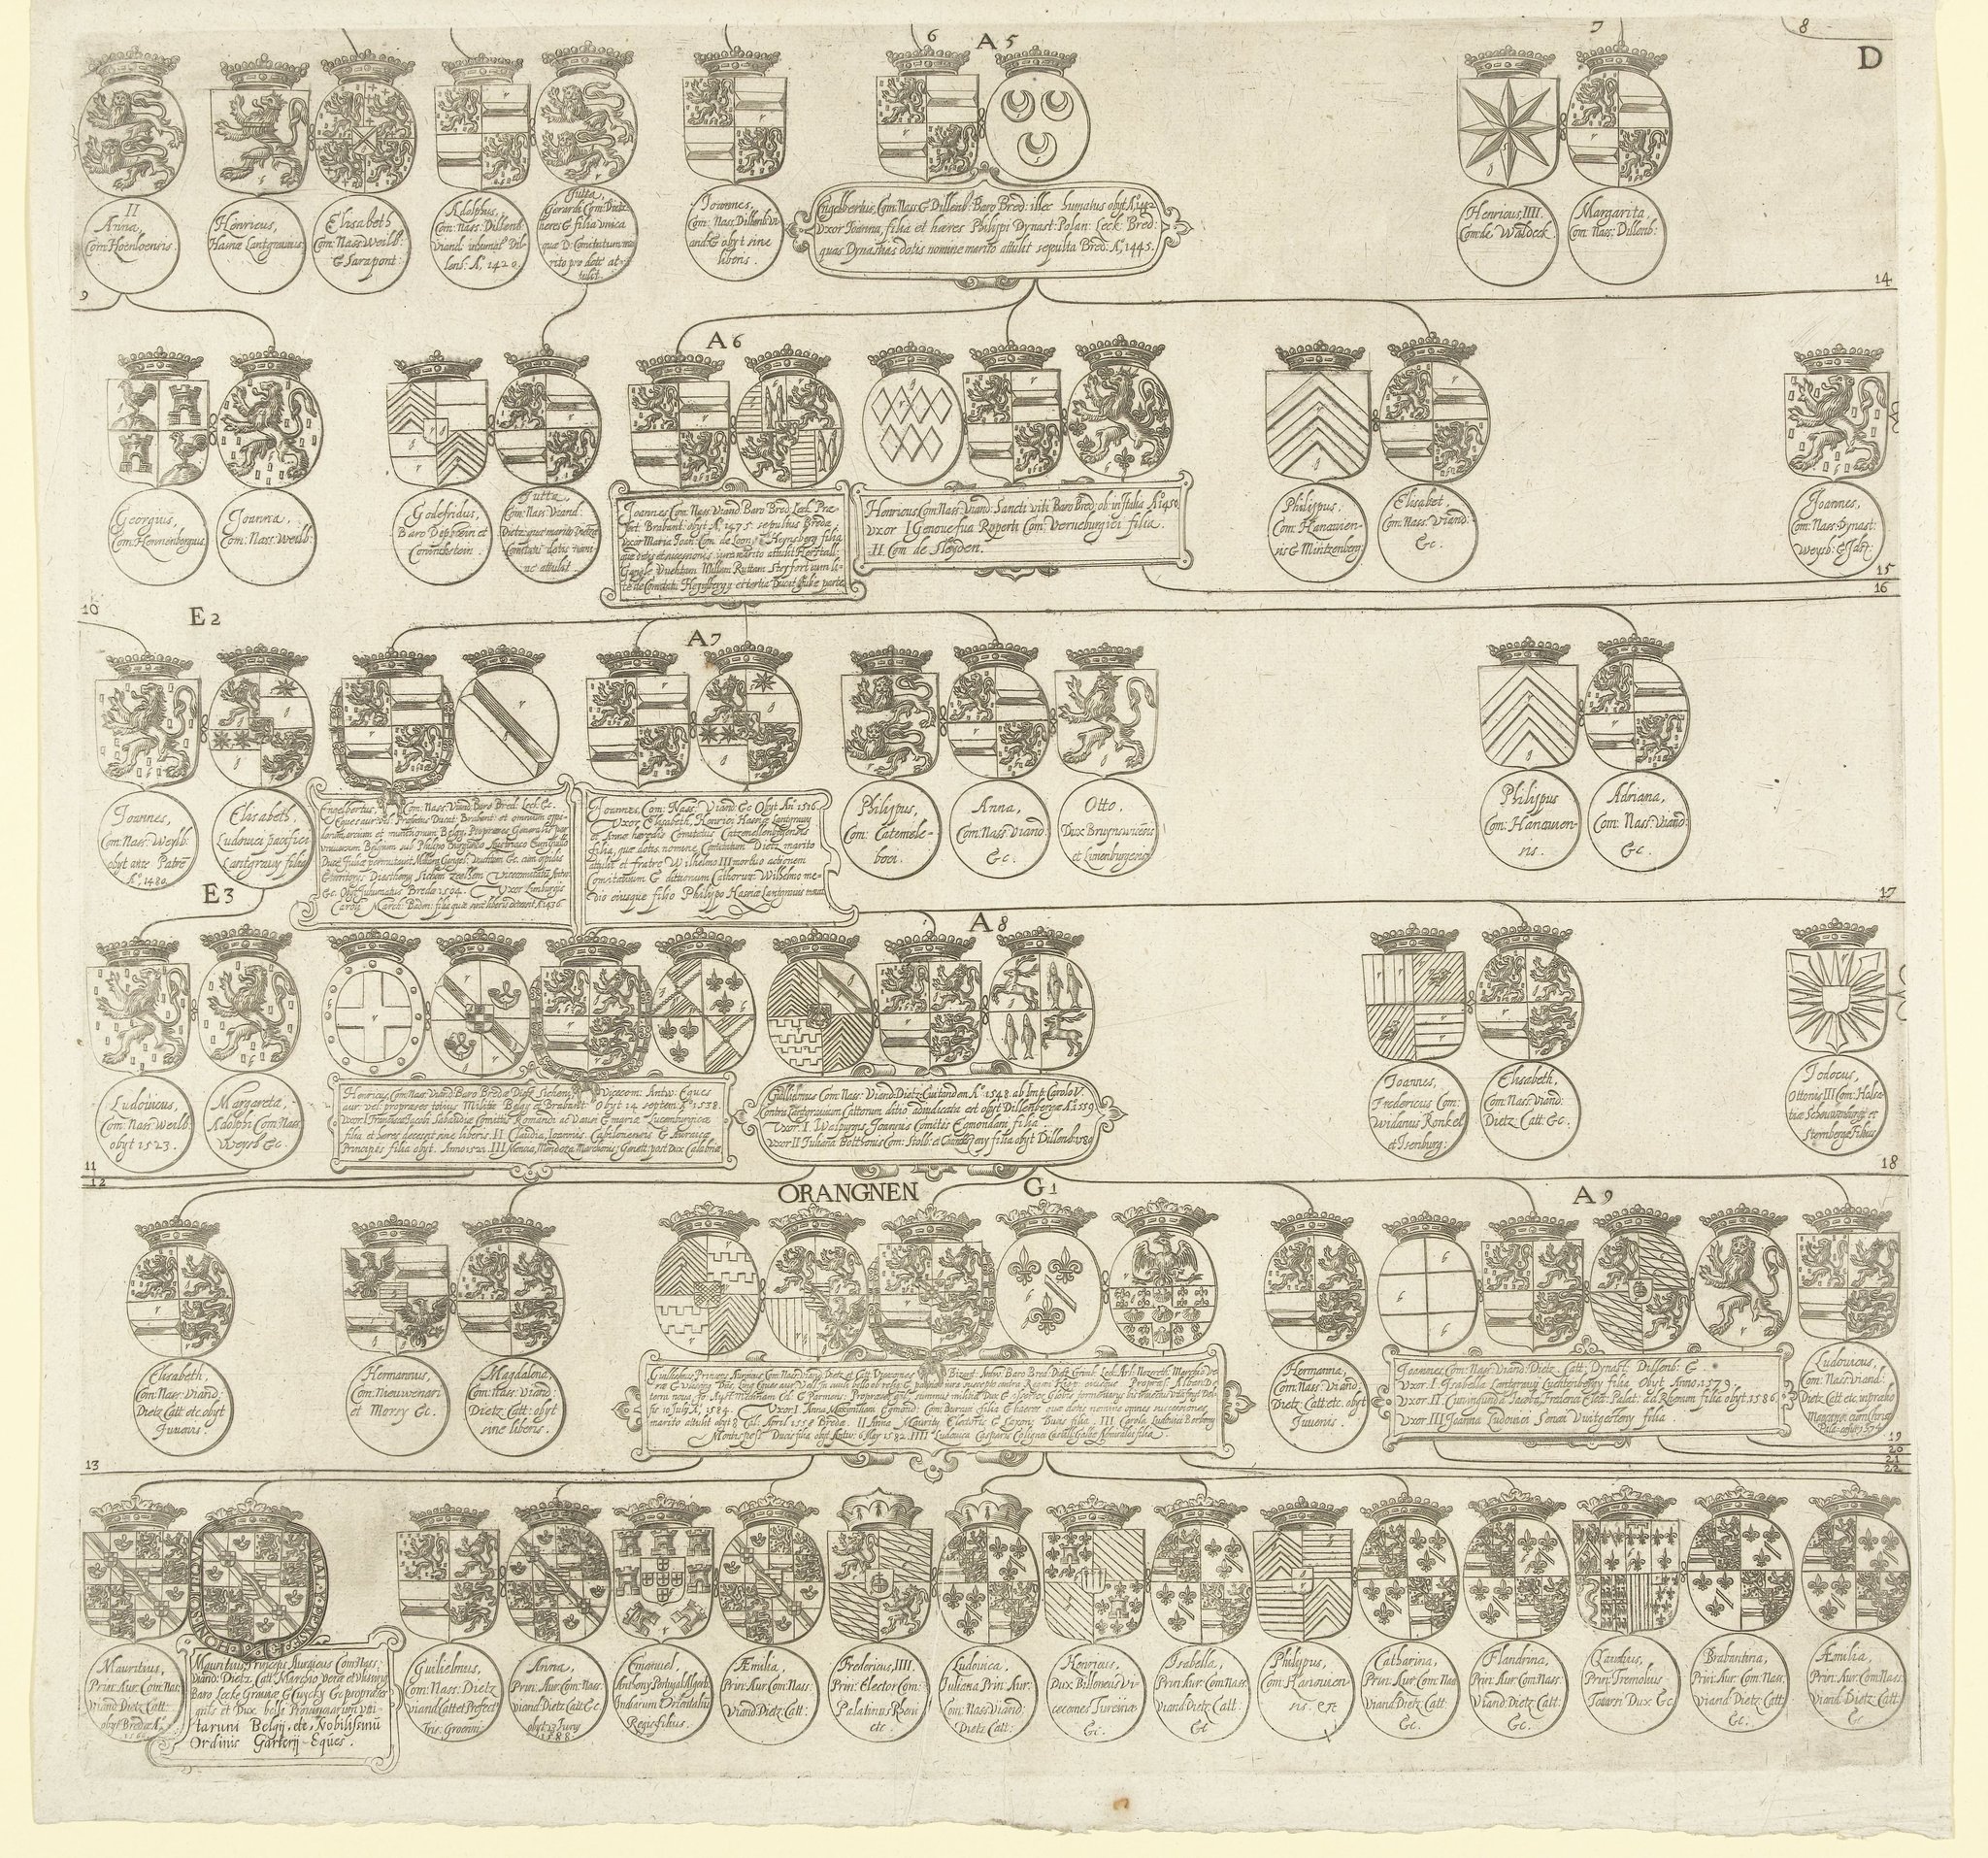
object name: print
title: St. Familiae Comit. Nassauiorum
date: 1612-1619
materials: paper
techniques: engraving, etching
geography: leiden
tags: family lineage, pedigree, genealogical tree or table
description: Stamboom van het Huis Nassau, van 972 tot en met 1612, blad D in een reeks van zeven bladen gemerkt A-G. Meerdere wapens met in cirkels en cartouches namen, titels en jaartallen.